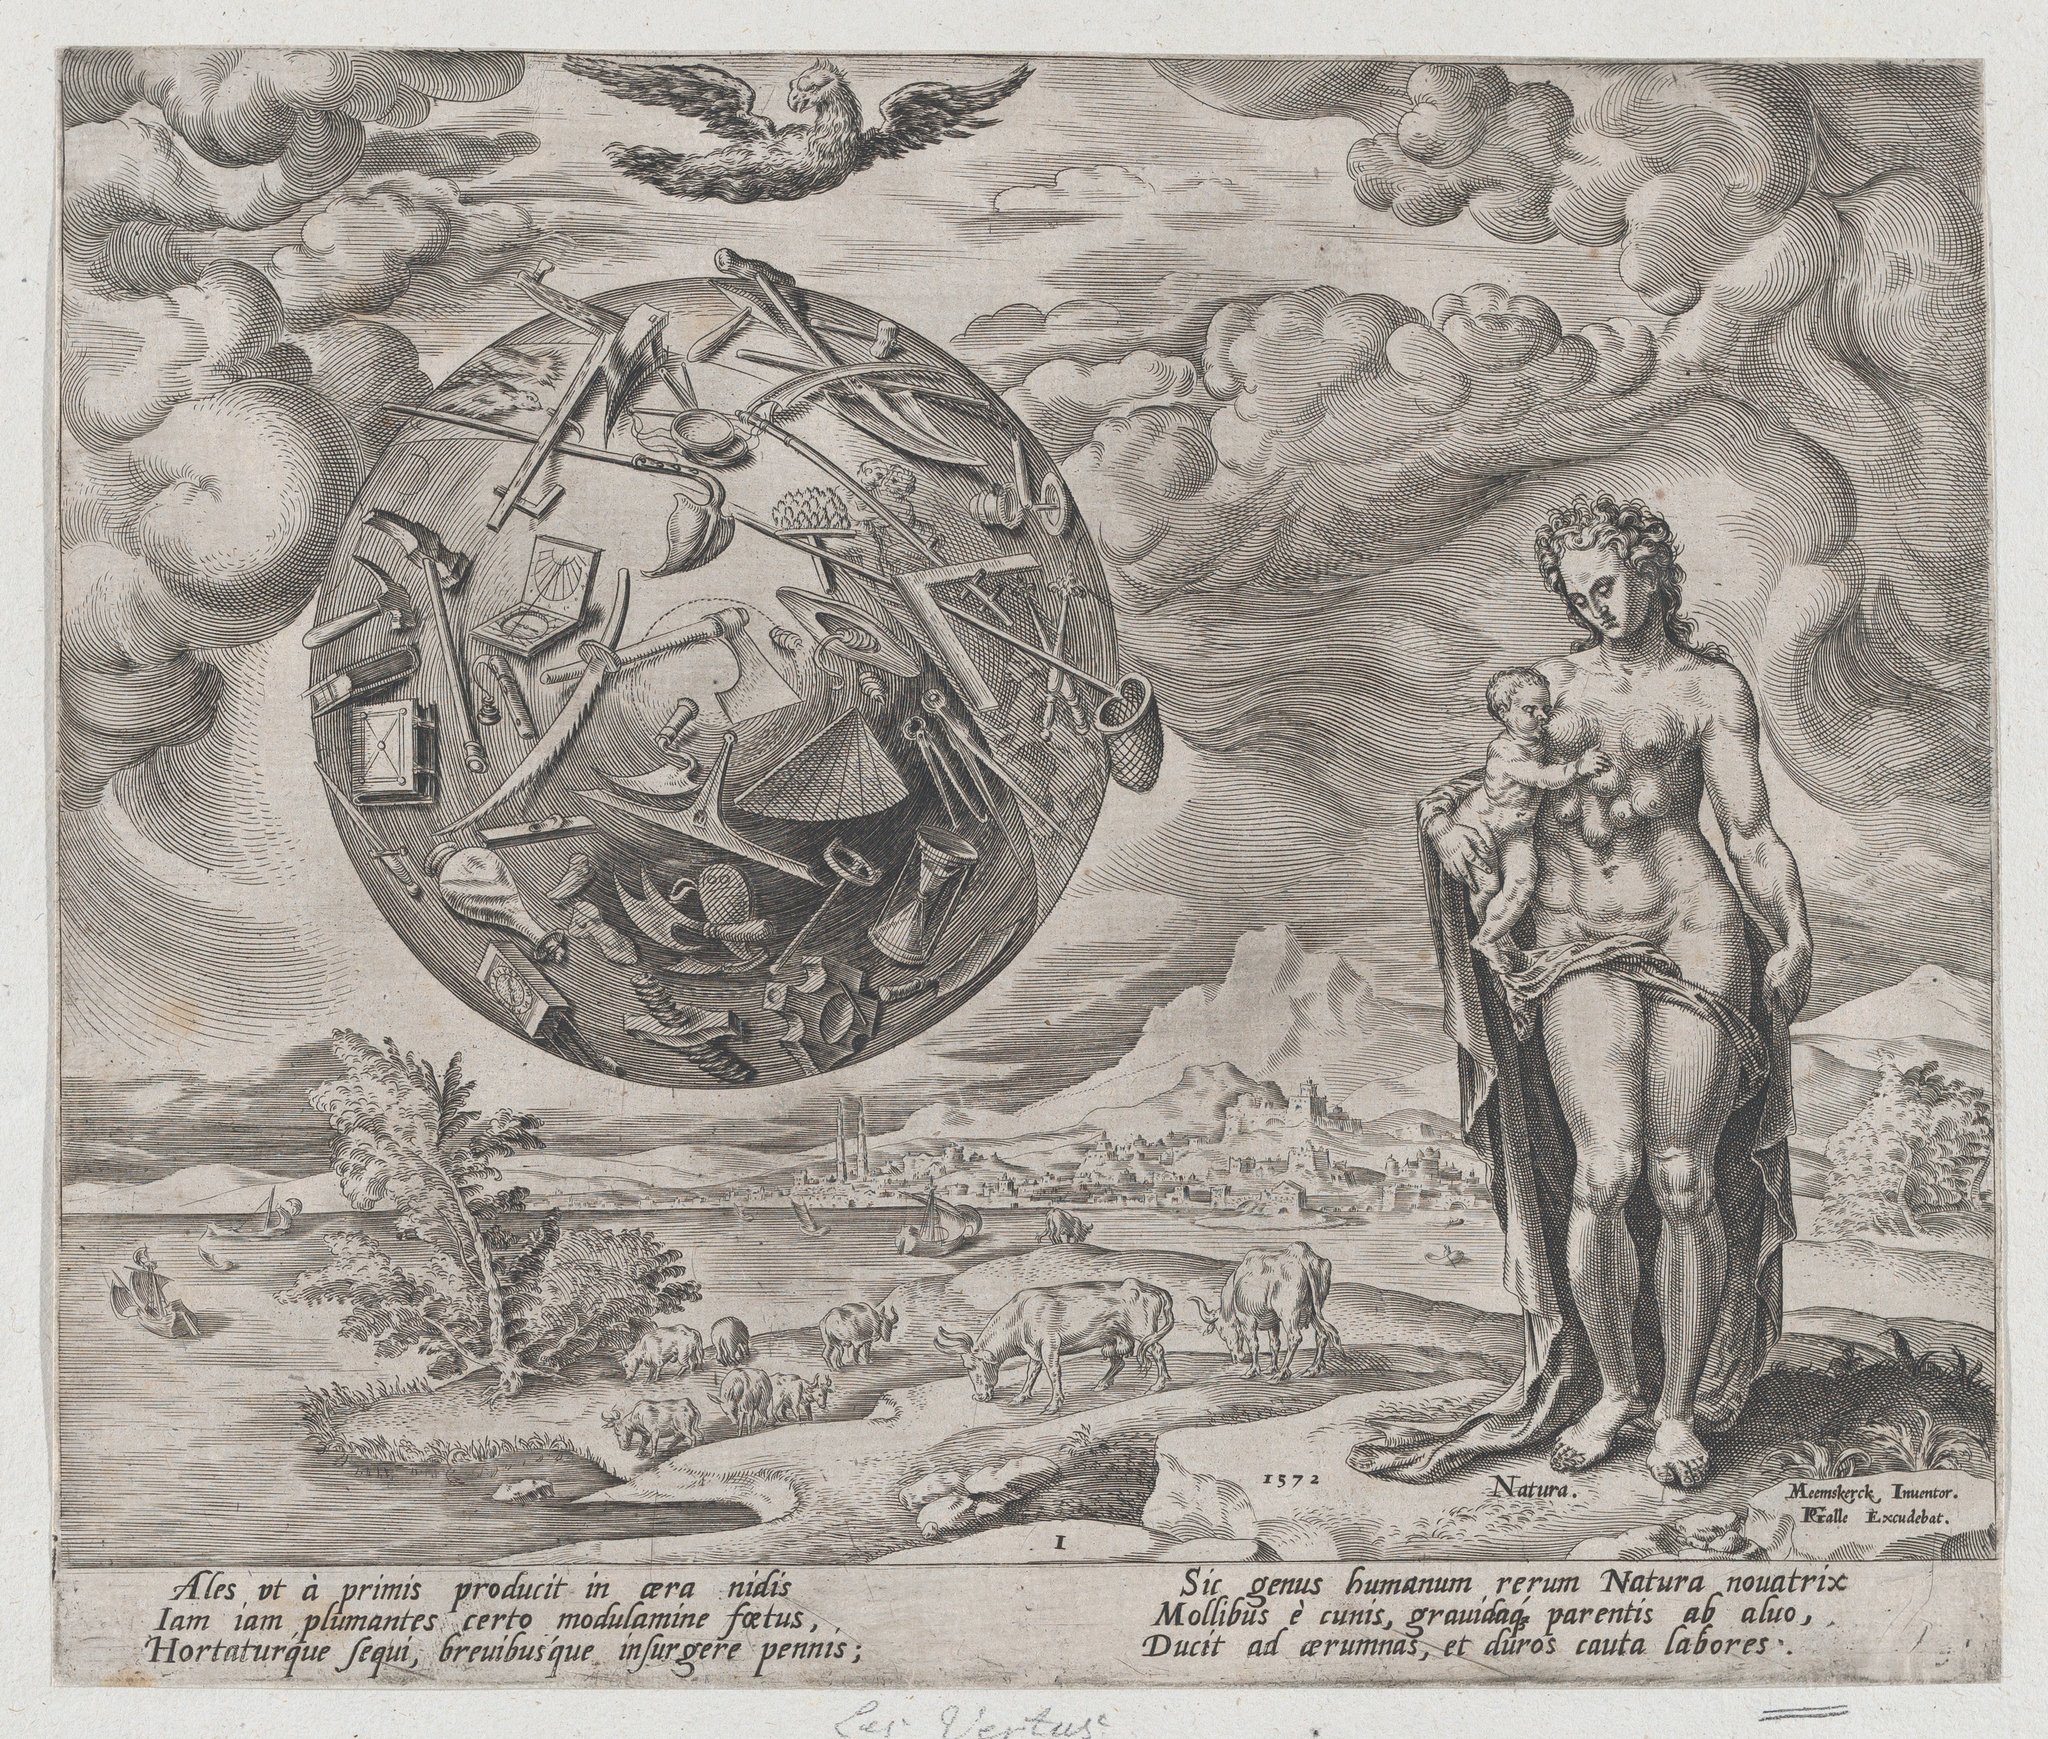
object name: print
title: Man Born to Toil, from The Reward of Labour and Diligence, plate 1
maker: philips galle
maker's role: artist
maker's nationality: netherlandish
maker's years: 1537-1612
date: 1572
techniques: engraving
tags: animals,birds,infants,landscapes,goddess